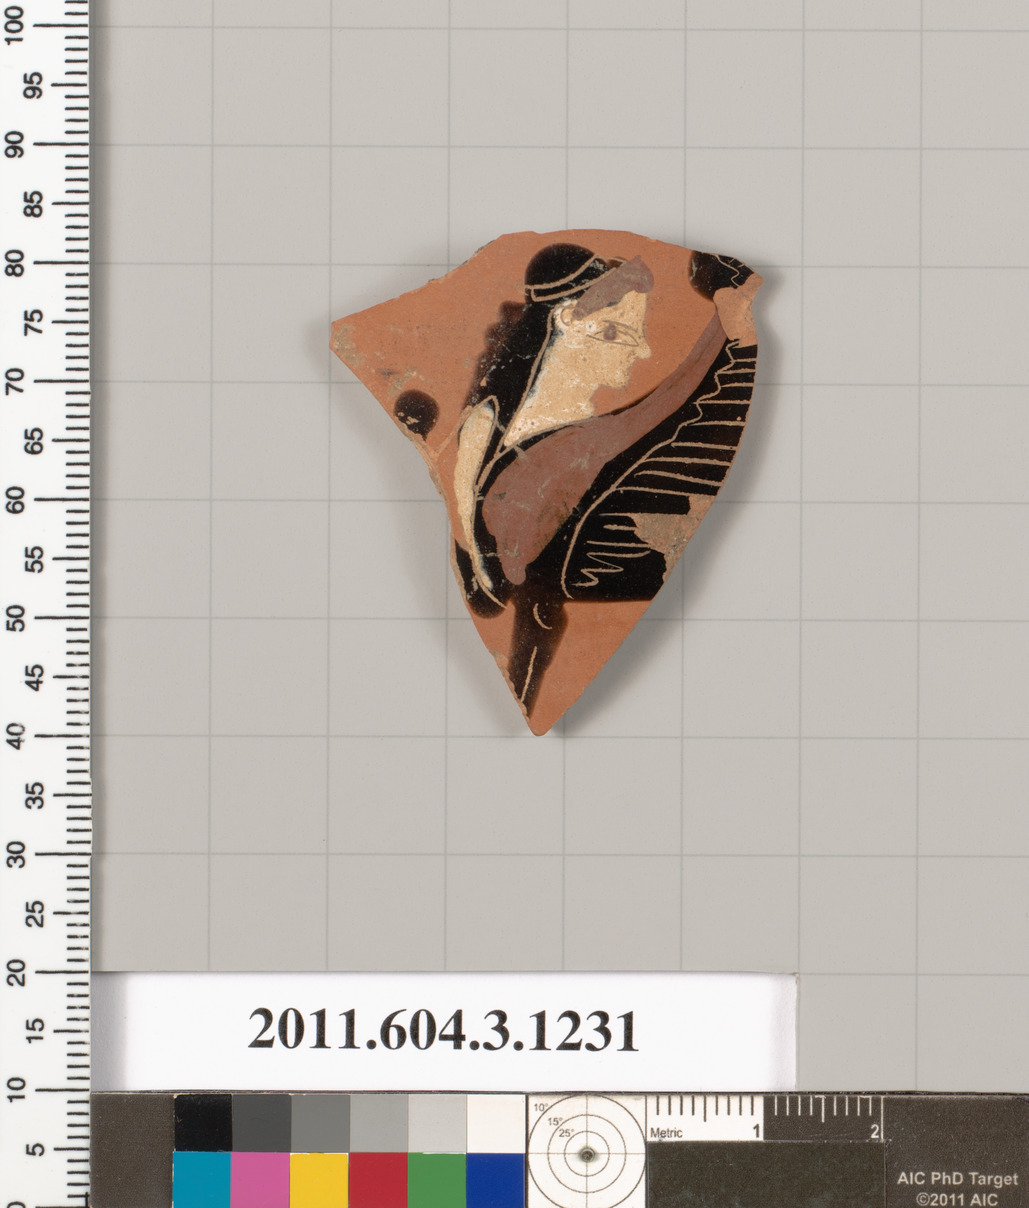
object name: kyathos fragment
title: Terracotta rim fragment of a kyathos (cup-shaped ladle)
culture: greek, attic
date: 534-468 BCE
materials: terracotta